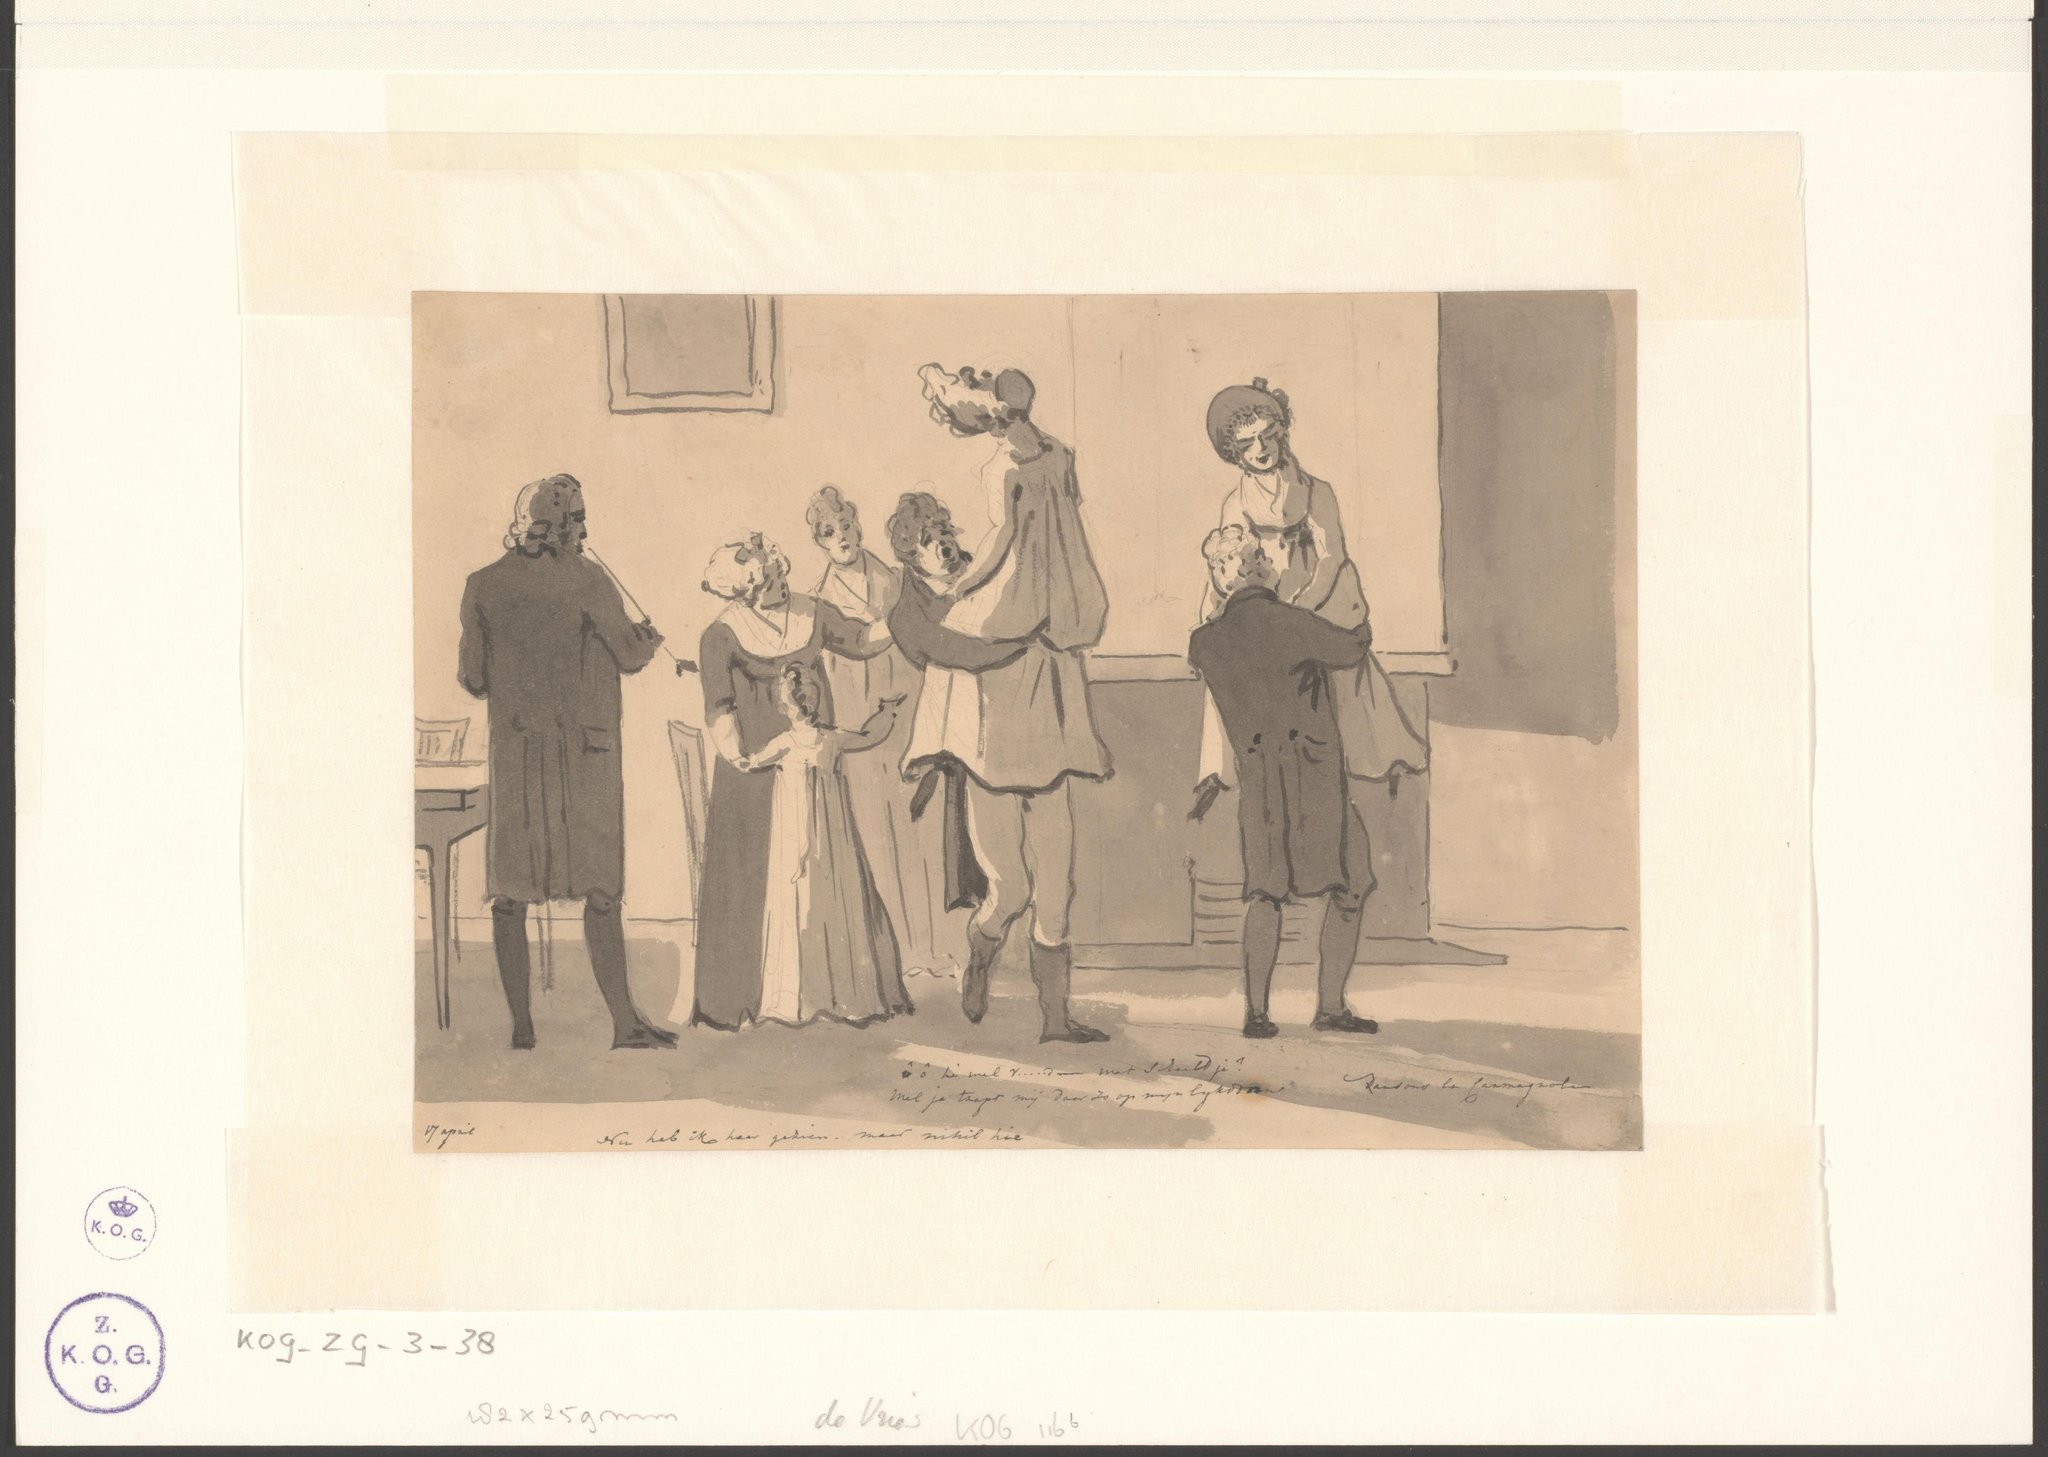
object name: drawing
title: Gezelschap danst de carmagnole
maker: christiaan andriessen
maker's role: draughtsman, print maker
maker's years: 1775-1846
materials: ink, paper, pencil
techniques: brush, pen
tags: dancing, group dancing among upper classes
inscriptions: inscription: ‘J Andriessen’, collector's mark: Lugt 1641a, collector's mark: Lugt 1641, inscription: ‘17 april Nu heb ik haar gezien, maar nihil hic / ô ô hè wel v.....d wat scheeld je? Wel je trapt mij daar zo op myn lykdoren / Dansons la carmagnole’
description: Dagboekblad uit het getekende dagboek dat Christiaan Andriessen bijhield van 1805 tot en met 1808.